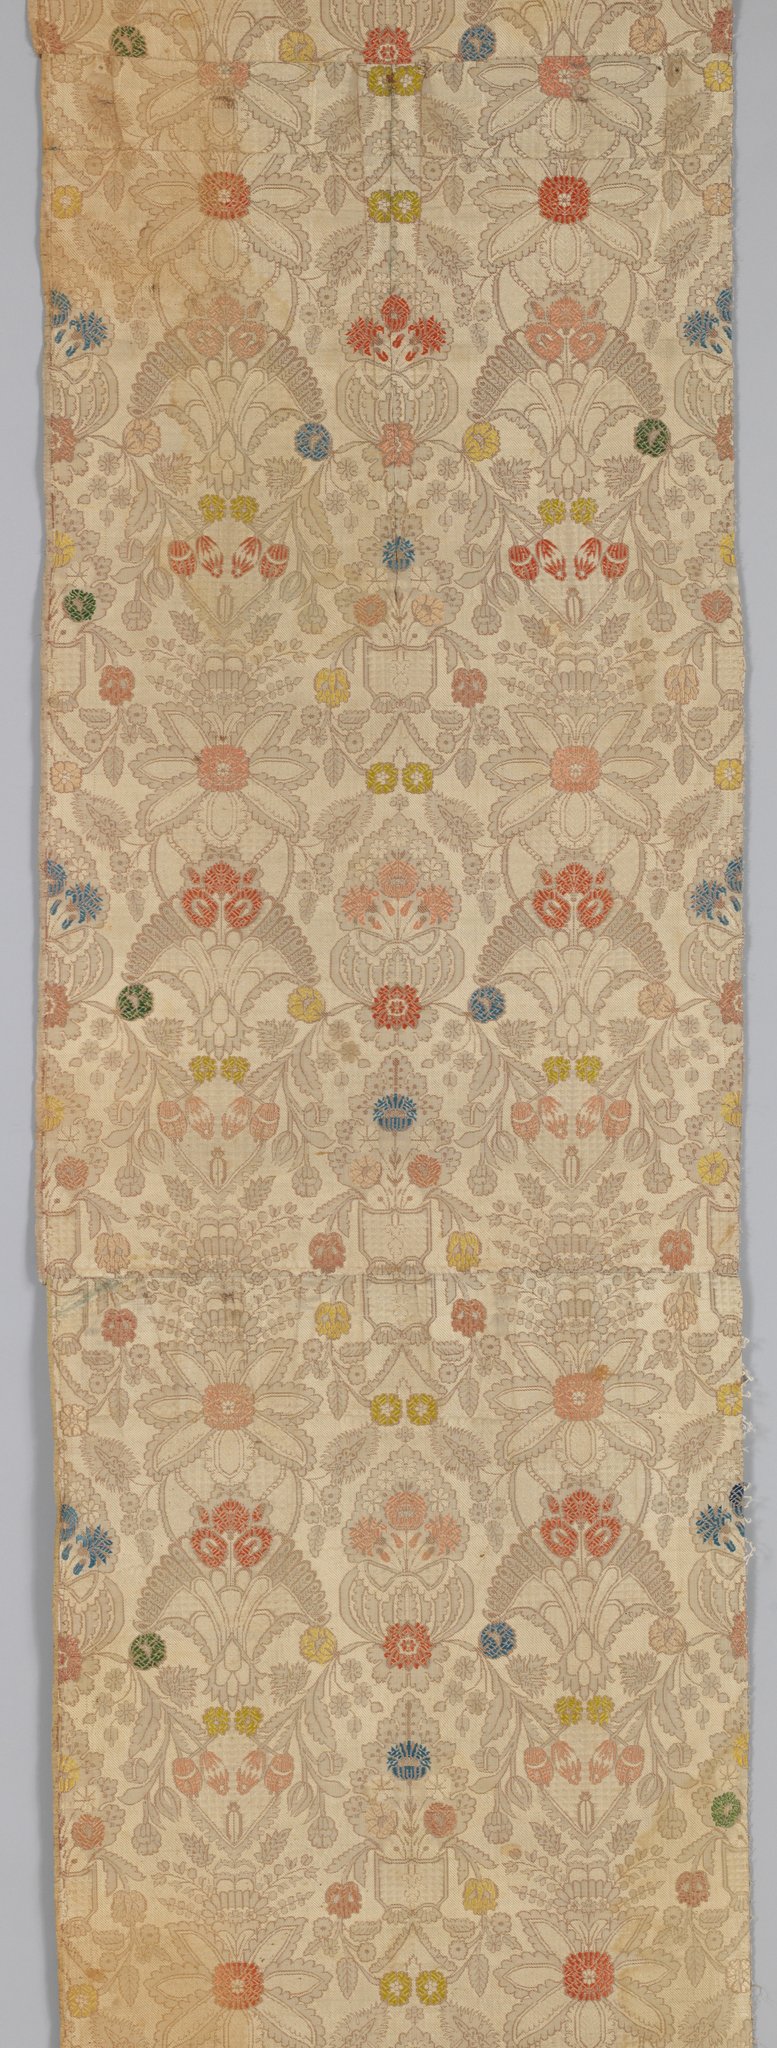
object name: panel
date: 1601-1700